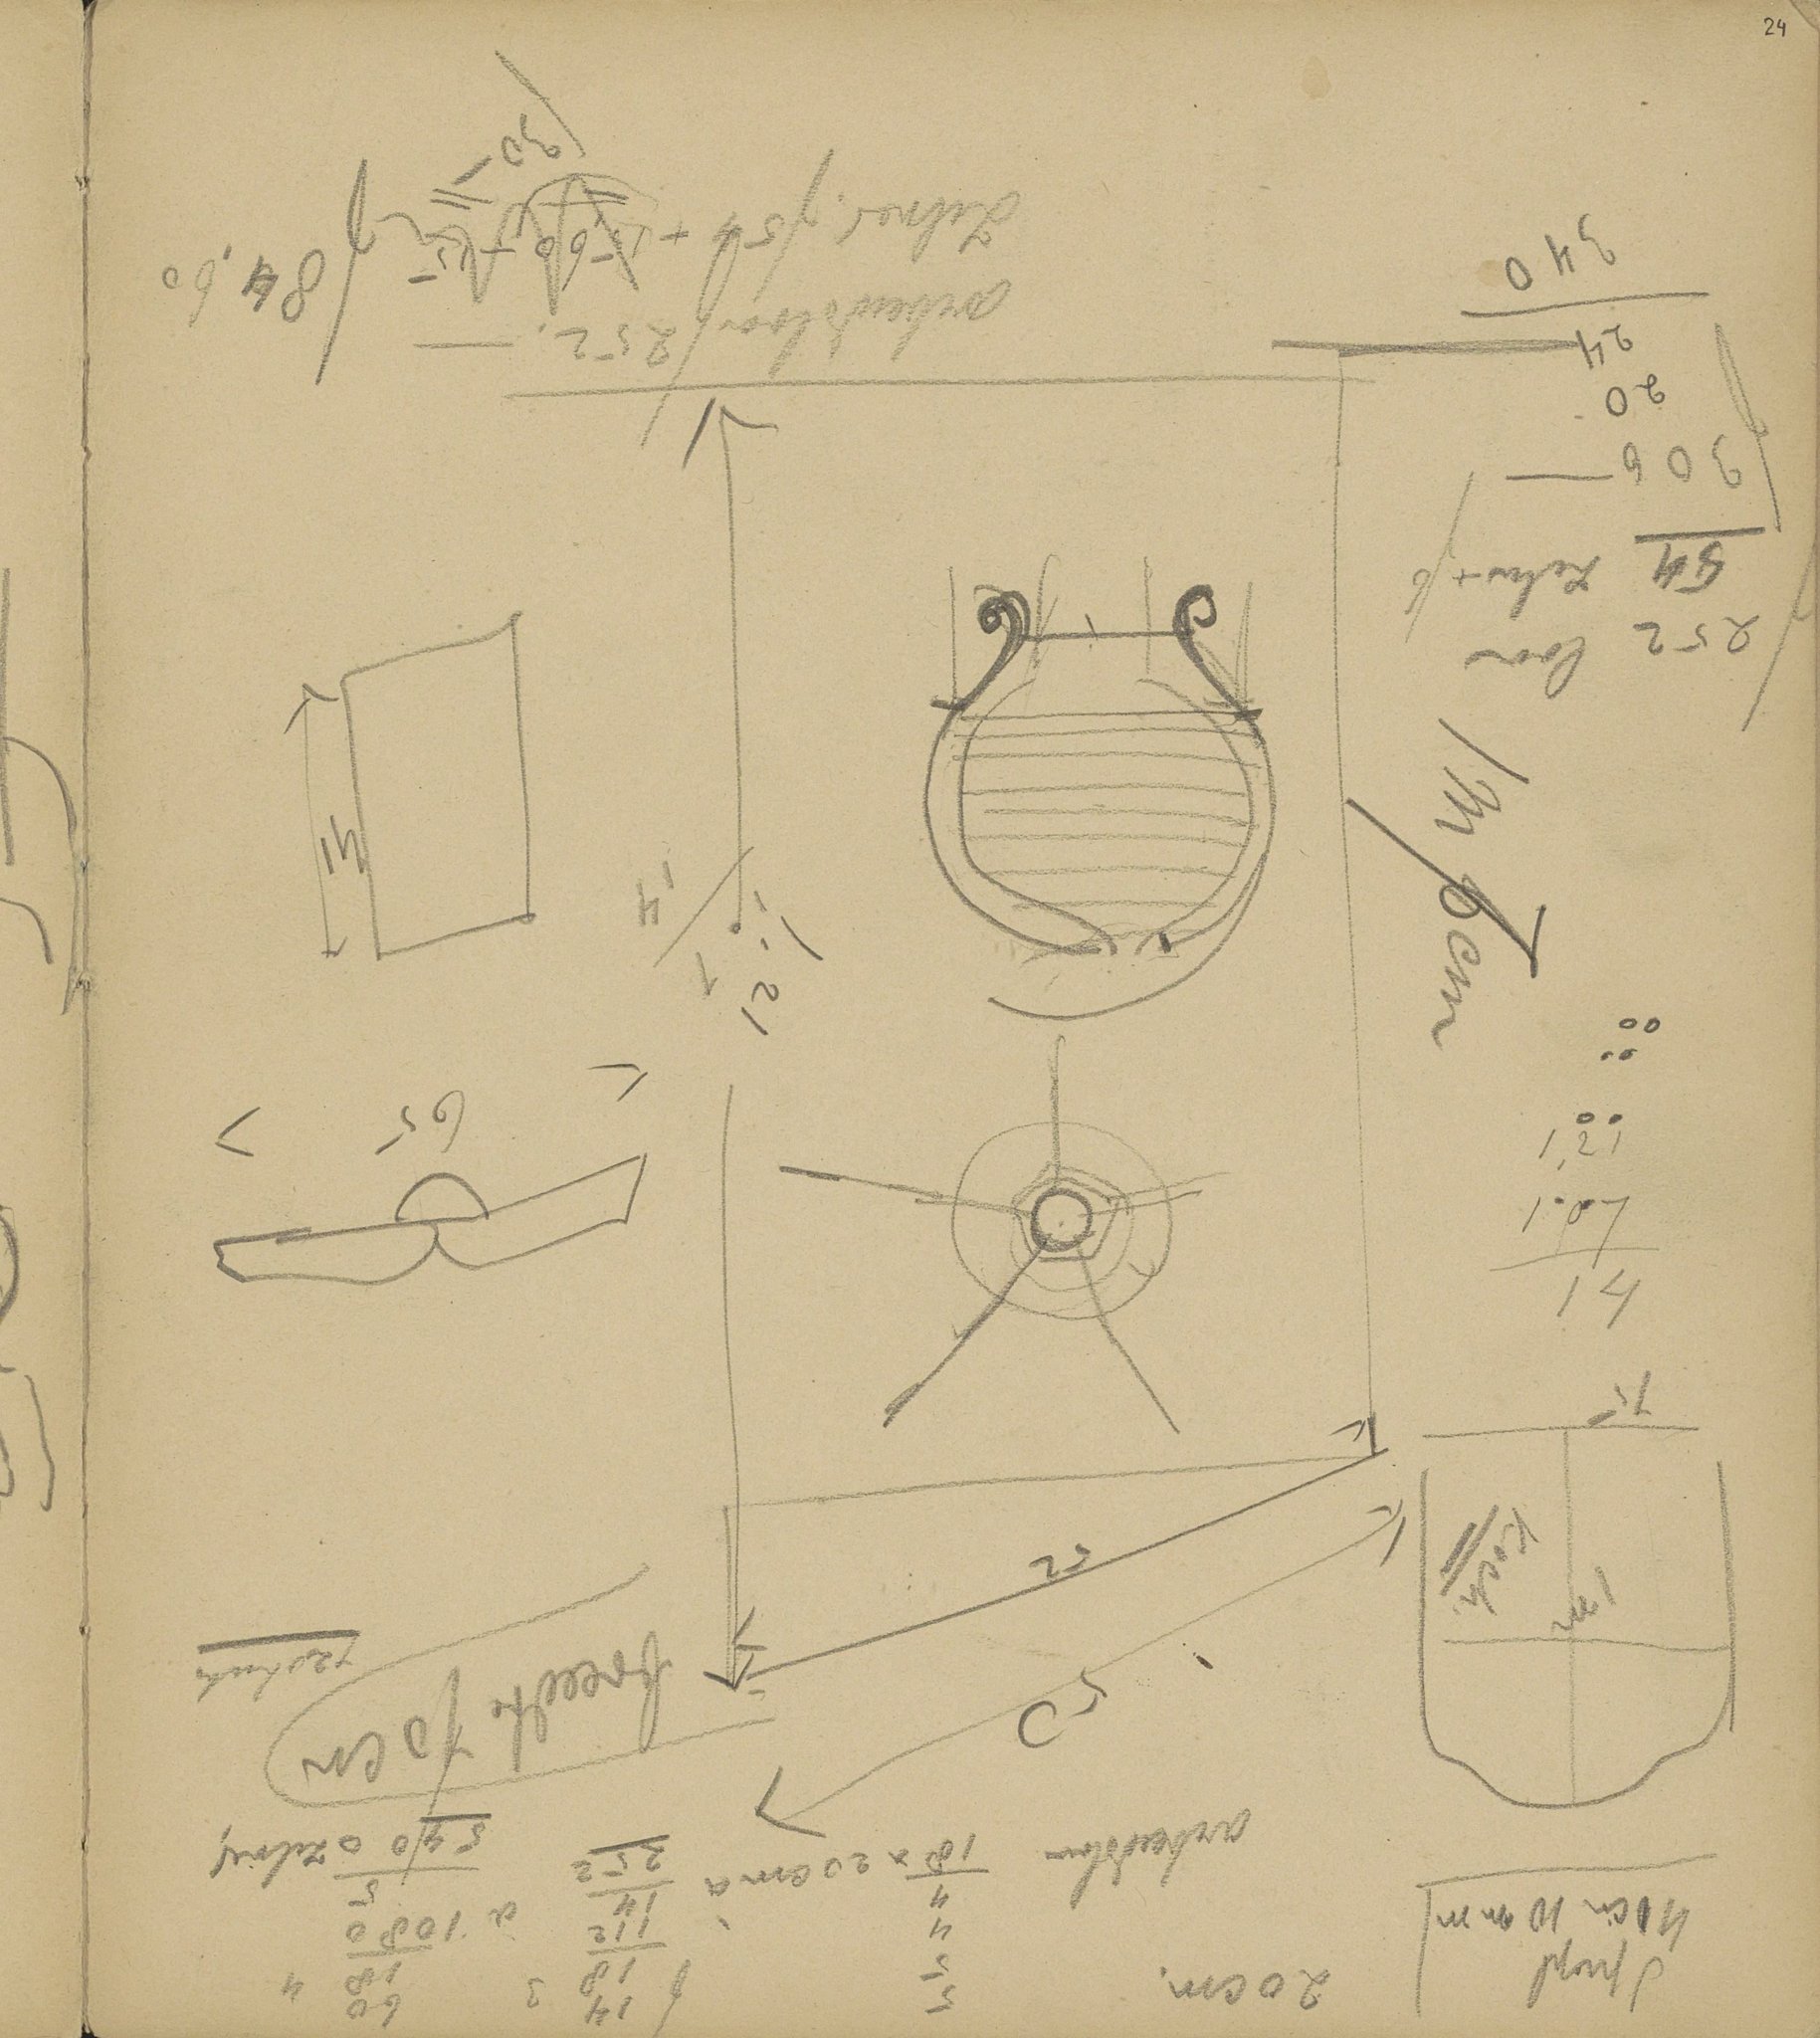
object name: sketchbook leaf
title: Studies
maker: carel adolph lion cachet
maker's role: draughtsman, print maker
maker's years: 1864-1945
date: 1906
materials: paper, pencil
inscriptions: annotation: ‘[...]’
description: Blad 24 recto uit een schetsboek met 27 bladen.